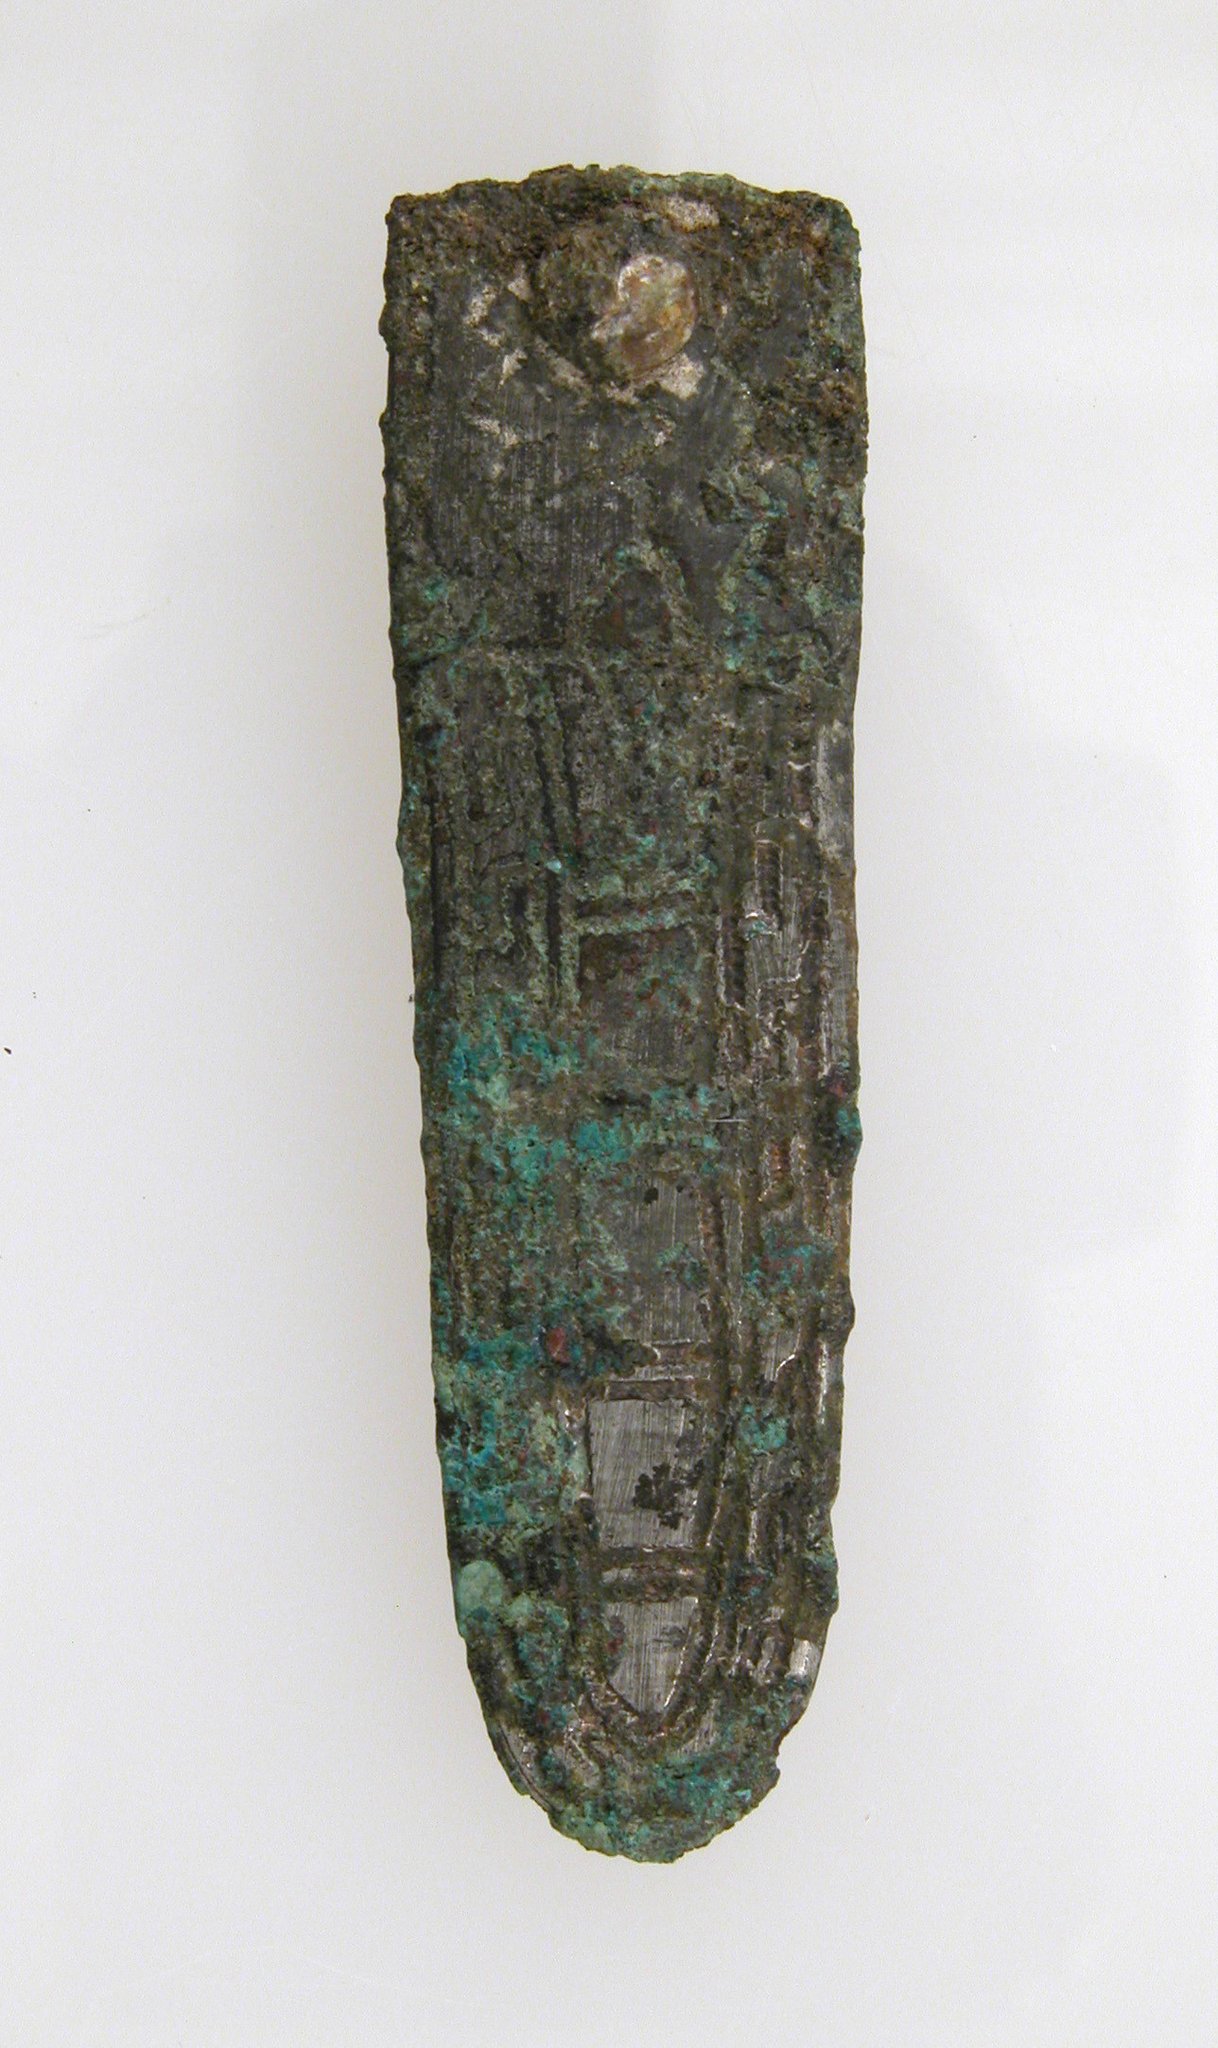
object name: ferret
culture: frankish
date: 501-700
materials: copper alloy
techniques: silvered